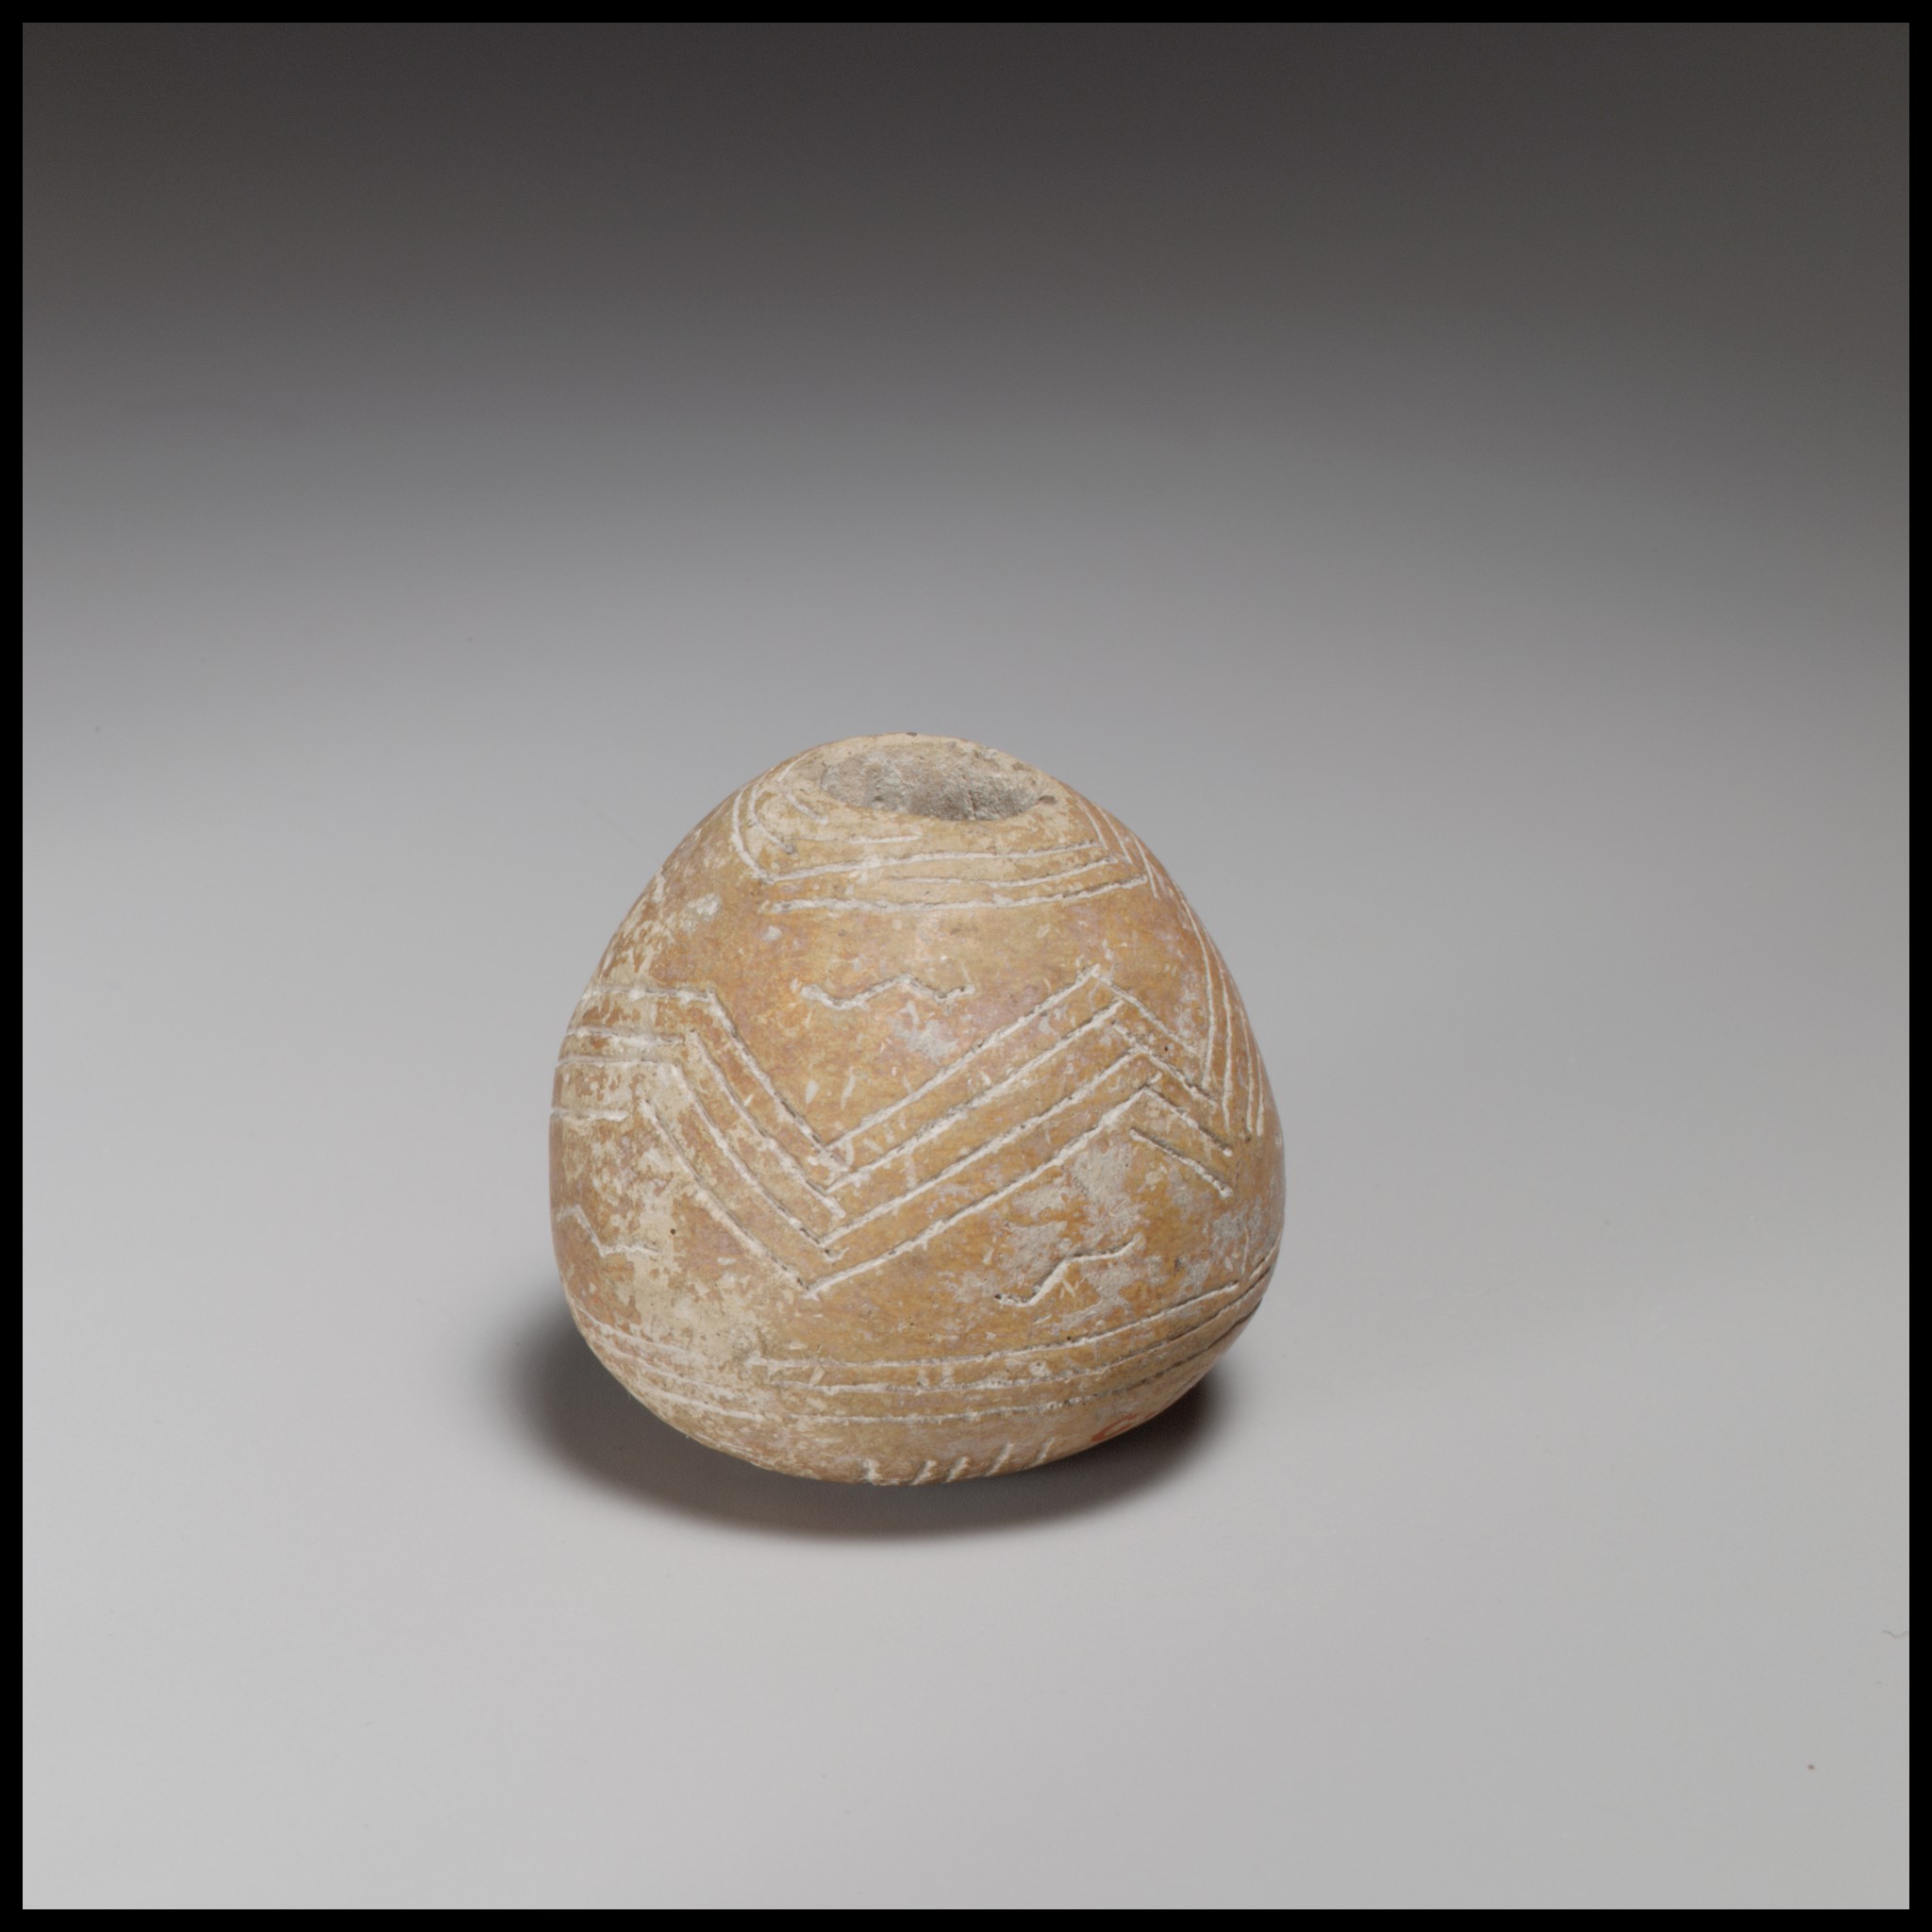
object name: spindle whorl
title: Terracotta conical-hemispherical spindle-whorl with rounded base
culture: cypriot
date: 2000-1800 BCE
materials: terracotta